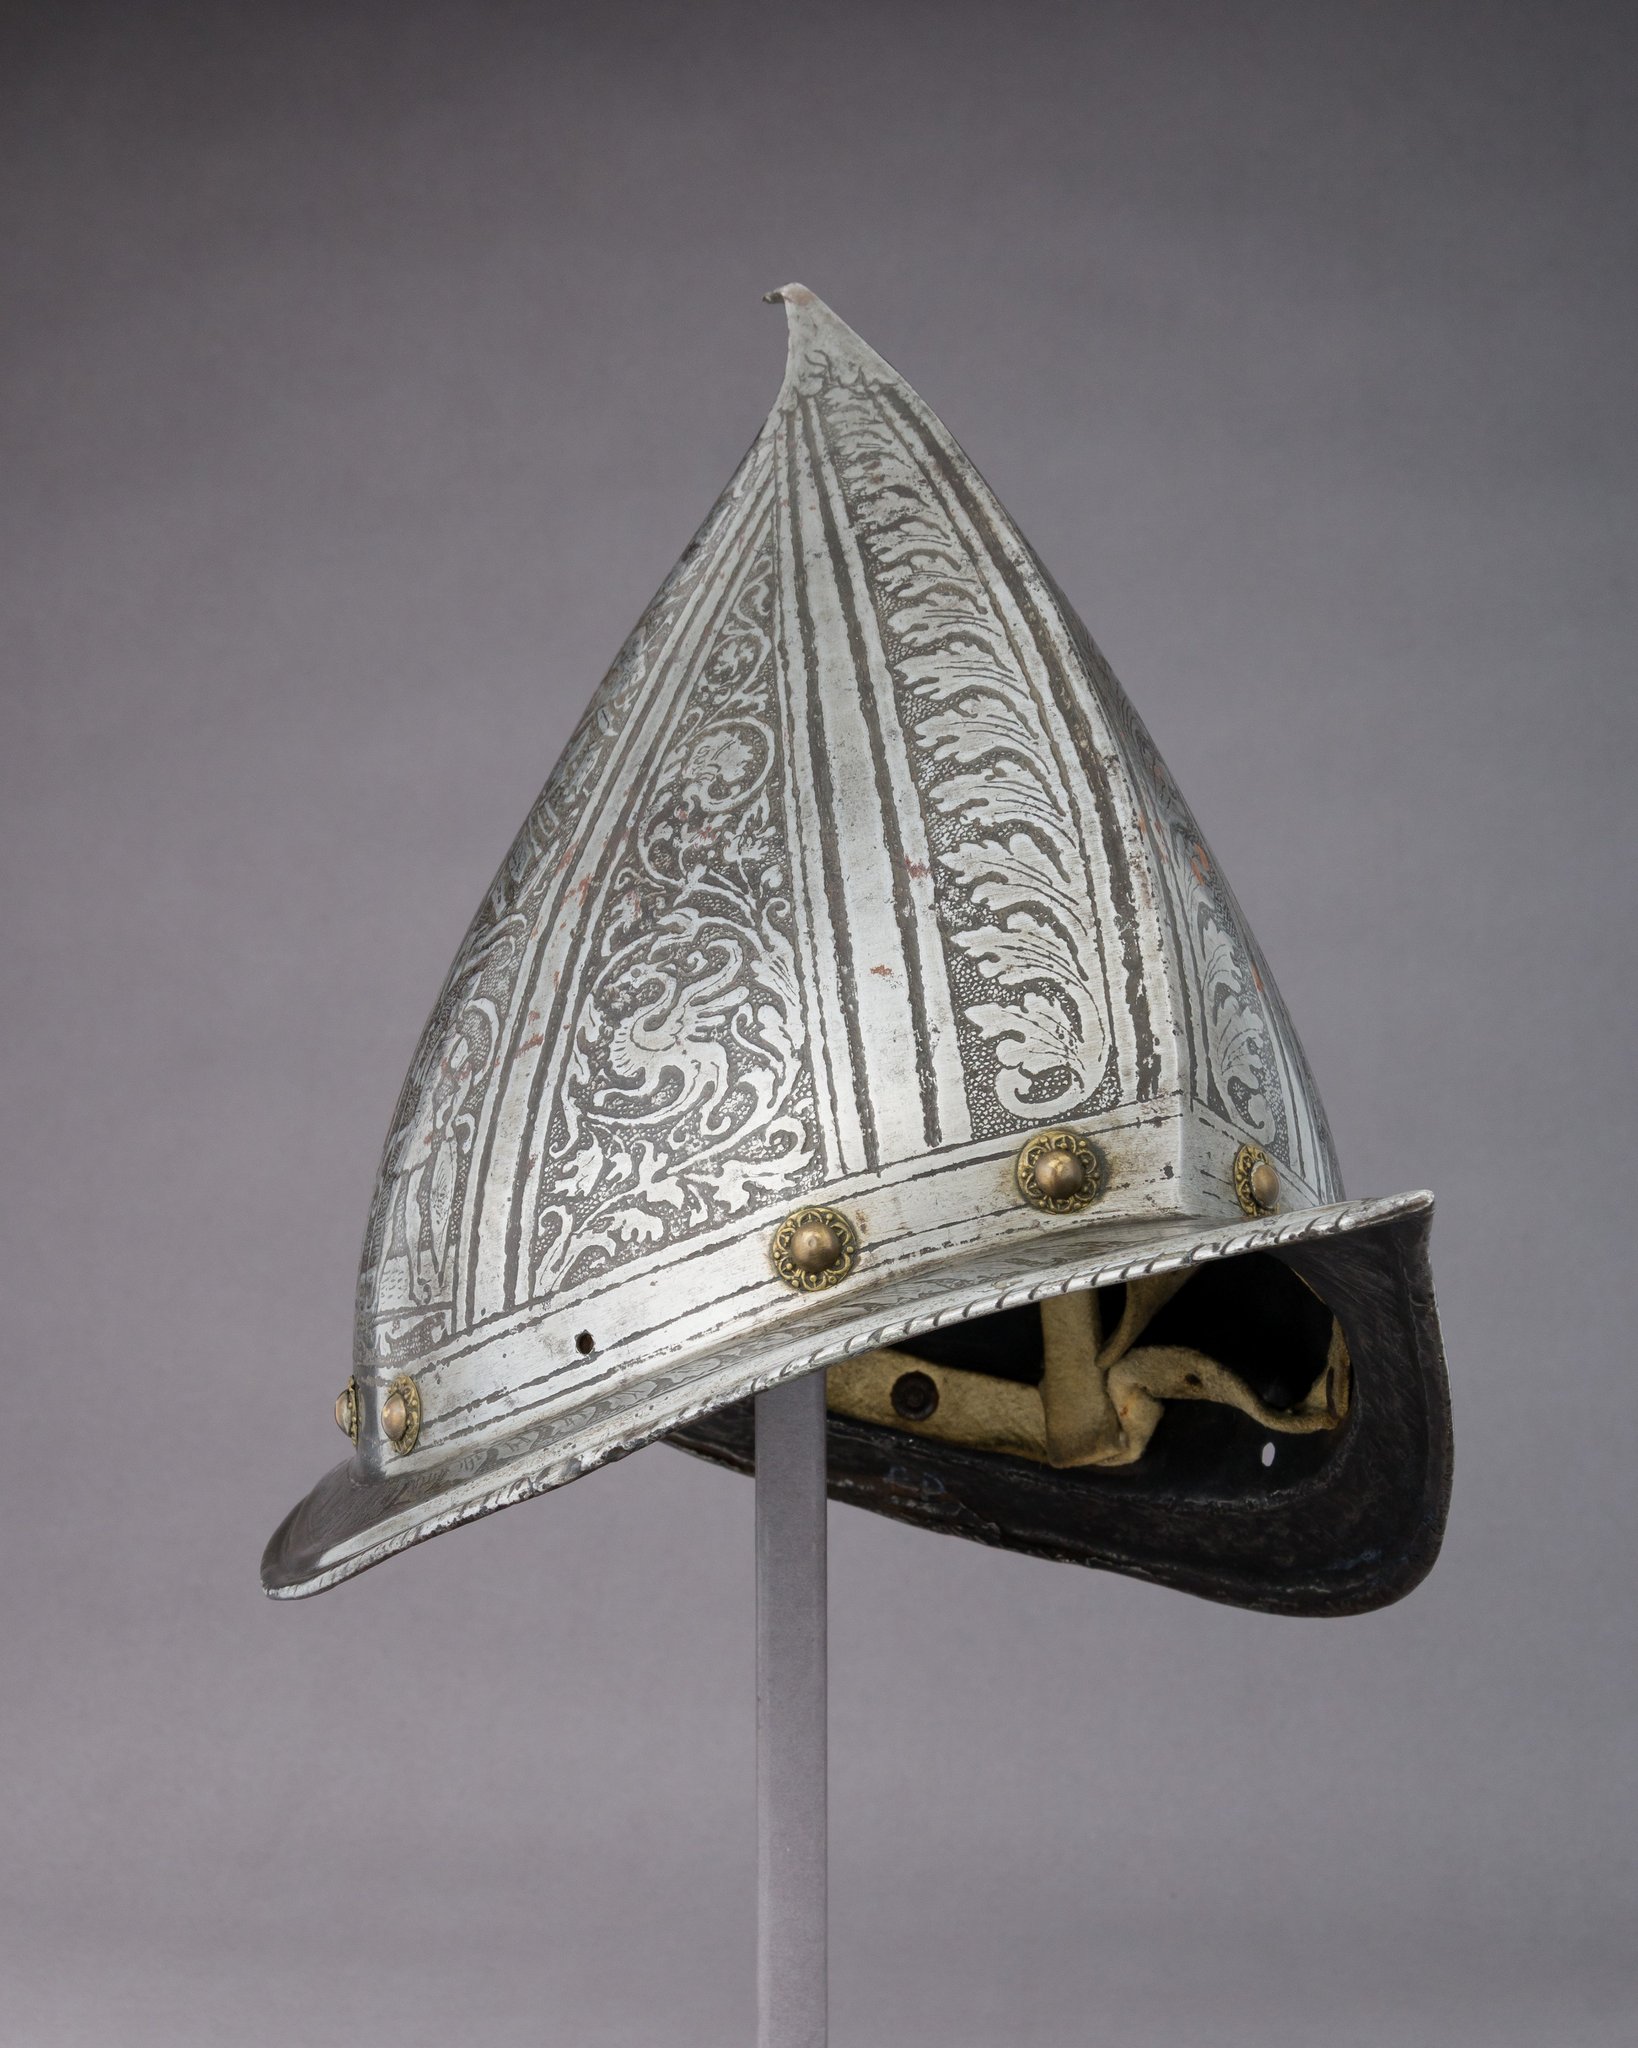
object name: morion cabasset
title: Morion-Cabasset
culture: italian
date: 1501-1600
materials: brass, leather, steel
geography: italy